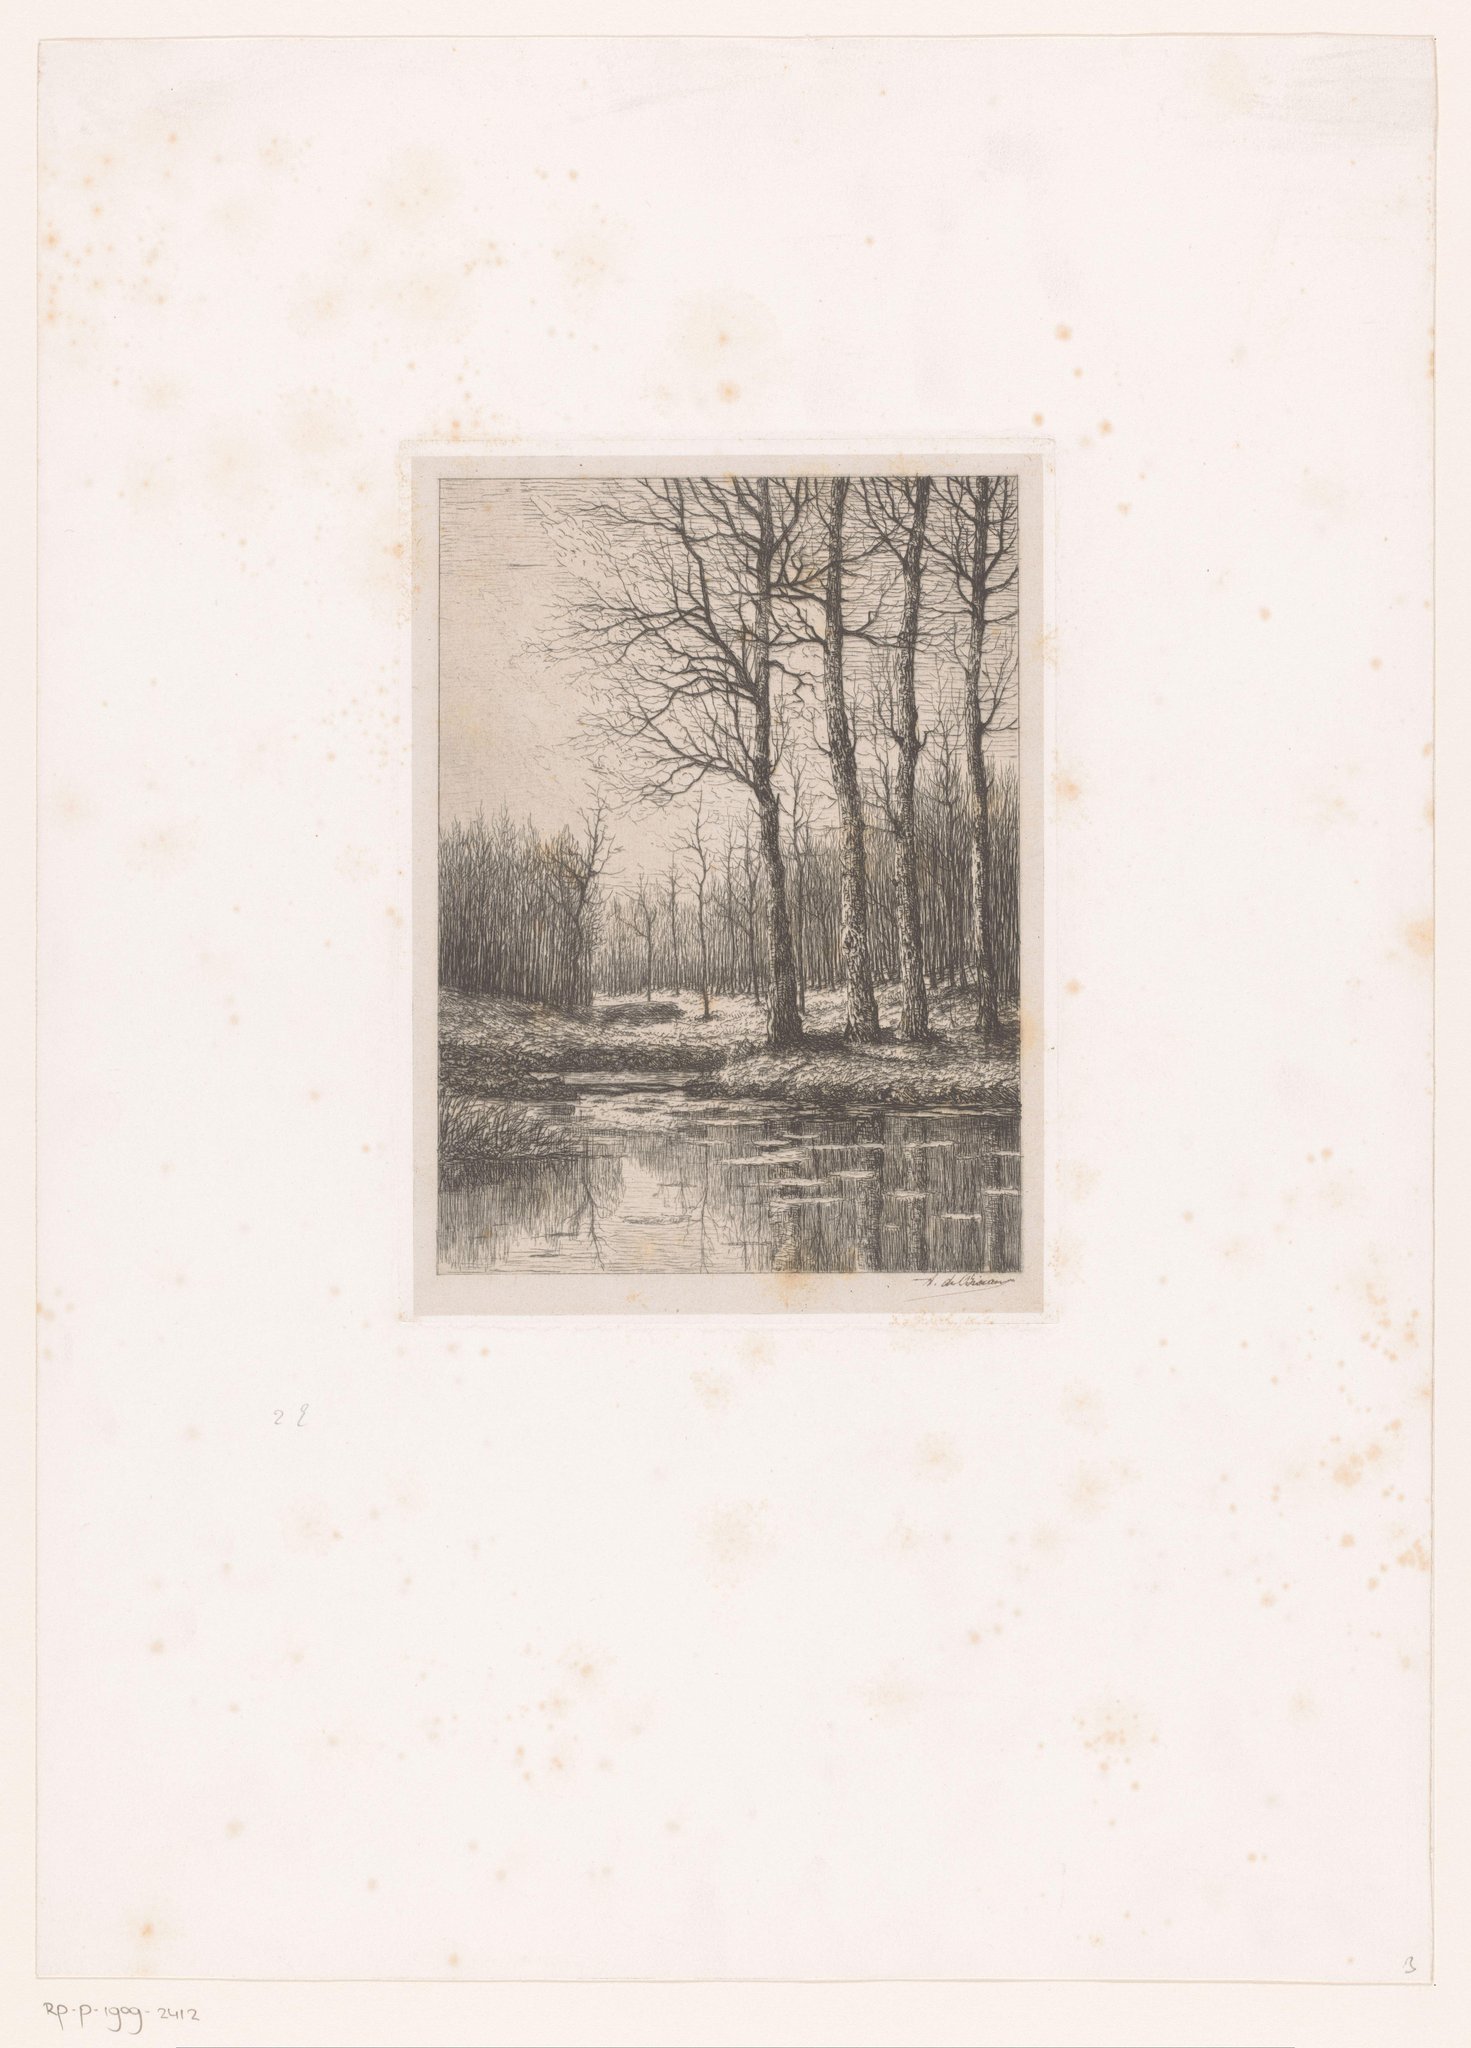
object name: print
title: Vier bomen bij een meer, daarachter kreupelhout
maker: aristide de biseau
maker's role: print maker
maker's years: 1844-1883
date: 1854-1883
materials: paper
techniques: etching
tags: forest, wood, pond, pool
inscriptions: collector's mark: Lugt 2228